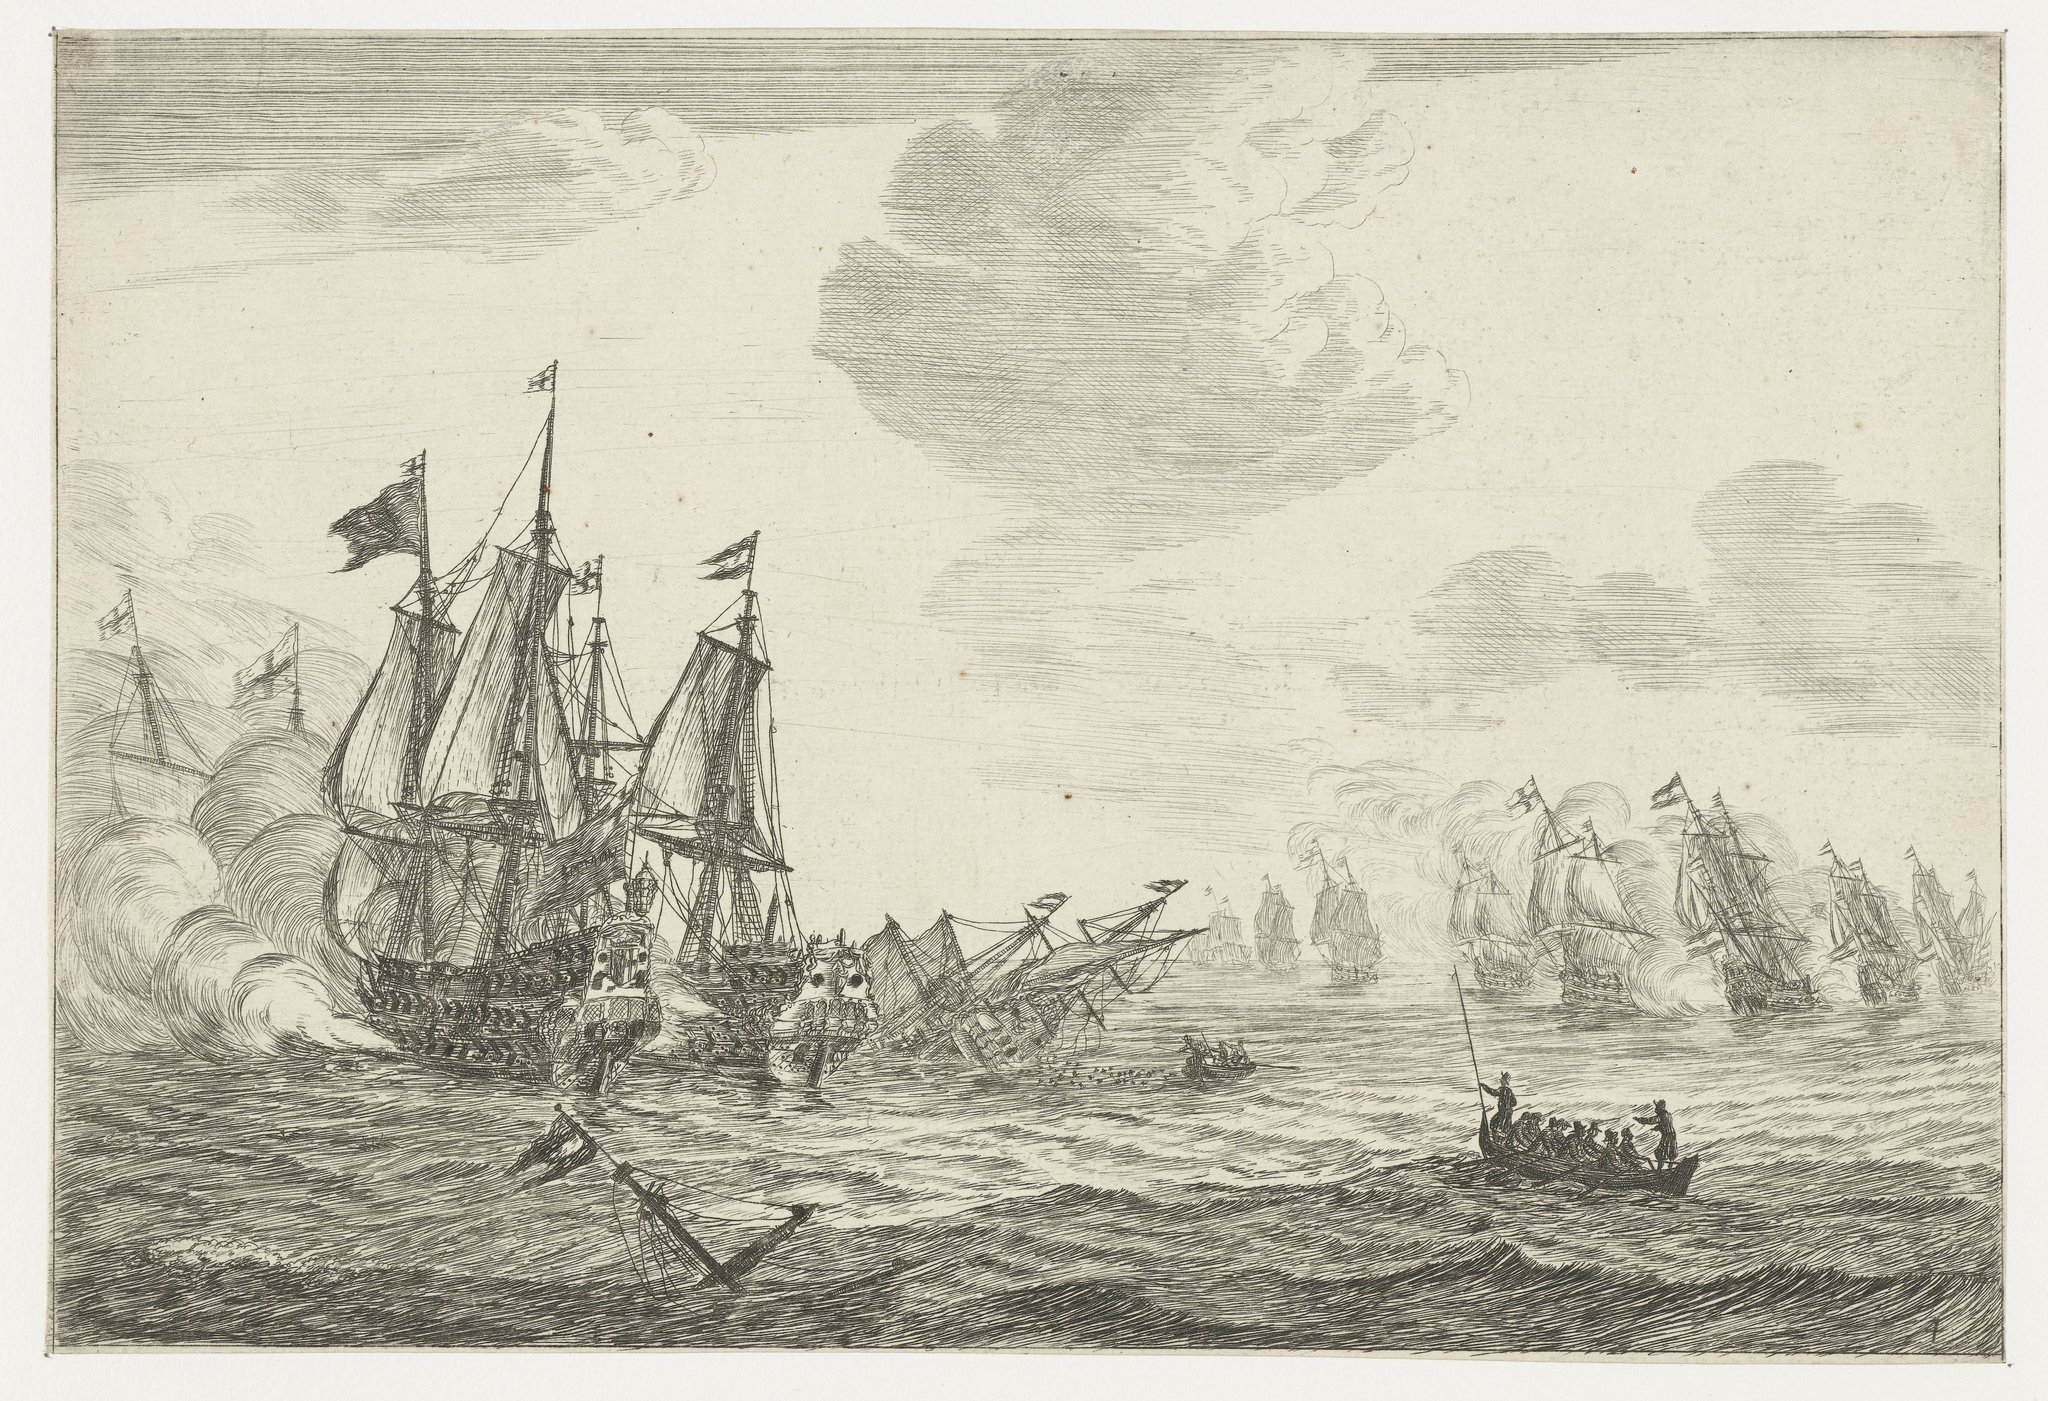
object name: print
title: Zeeslag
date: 1652-1670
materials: paper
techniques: drypoint, etching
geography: netherlands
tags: warfare; military affairs (+ sailing-ships), battle, fighting in general (+ naval force)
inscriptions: collector's mark: Lugt 2228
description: Zeeslag tussen Nederlandse en Engelse schepen. In het midden een zinkend schip, twee reddingssloepen met mensen, mast van een tweede gezonken schip nog zichtbaar.